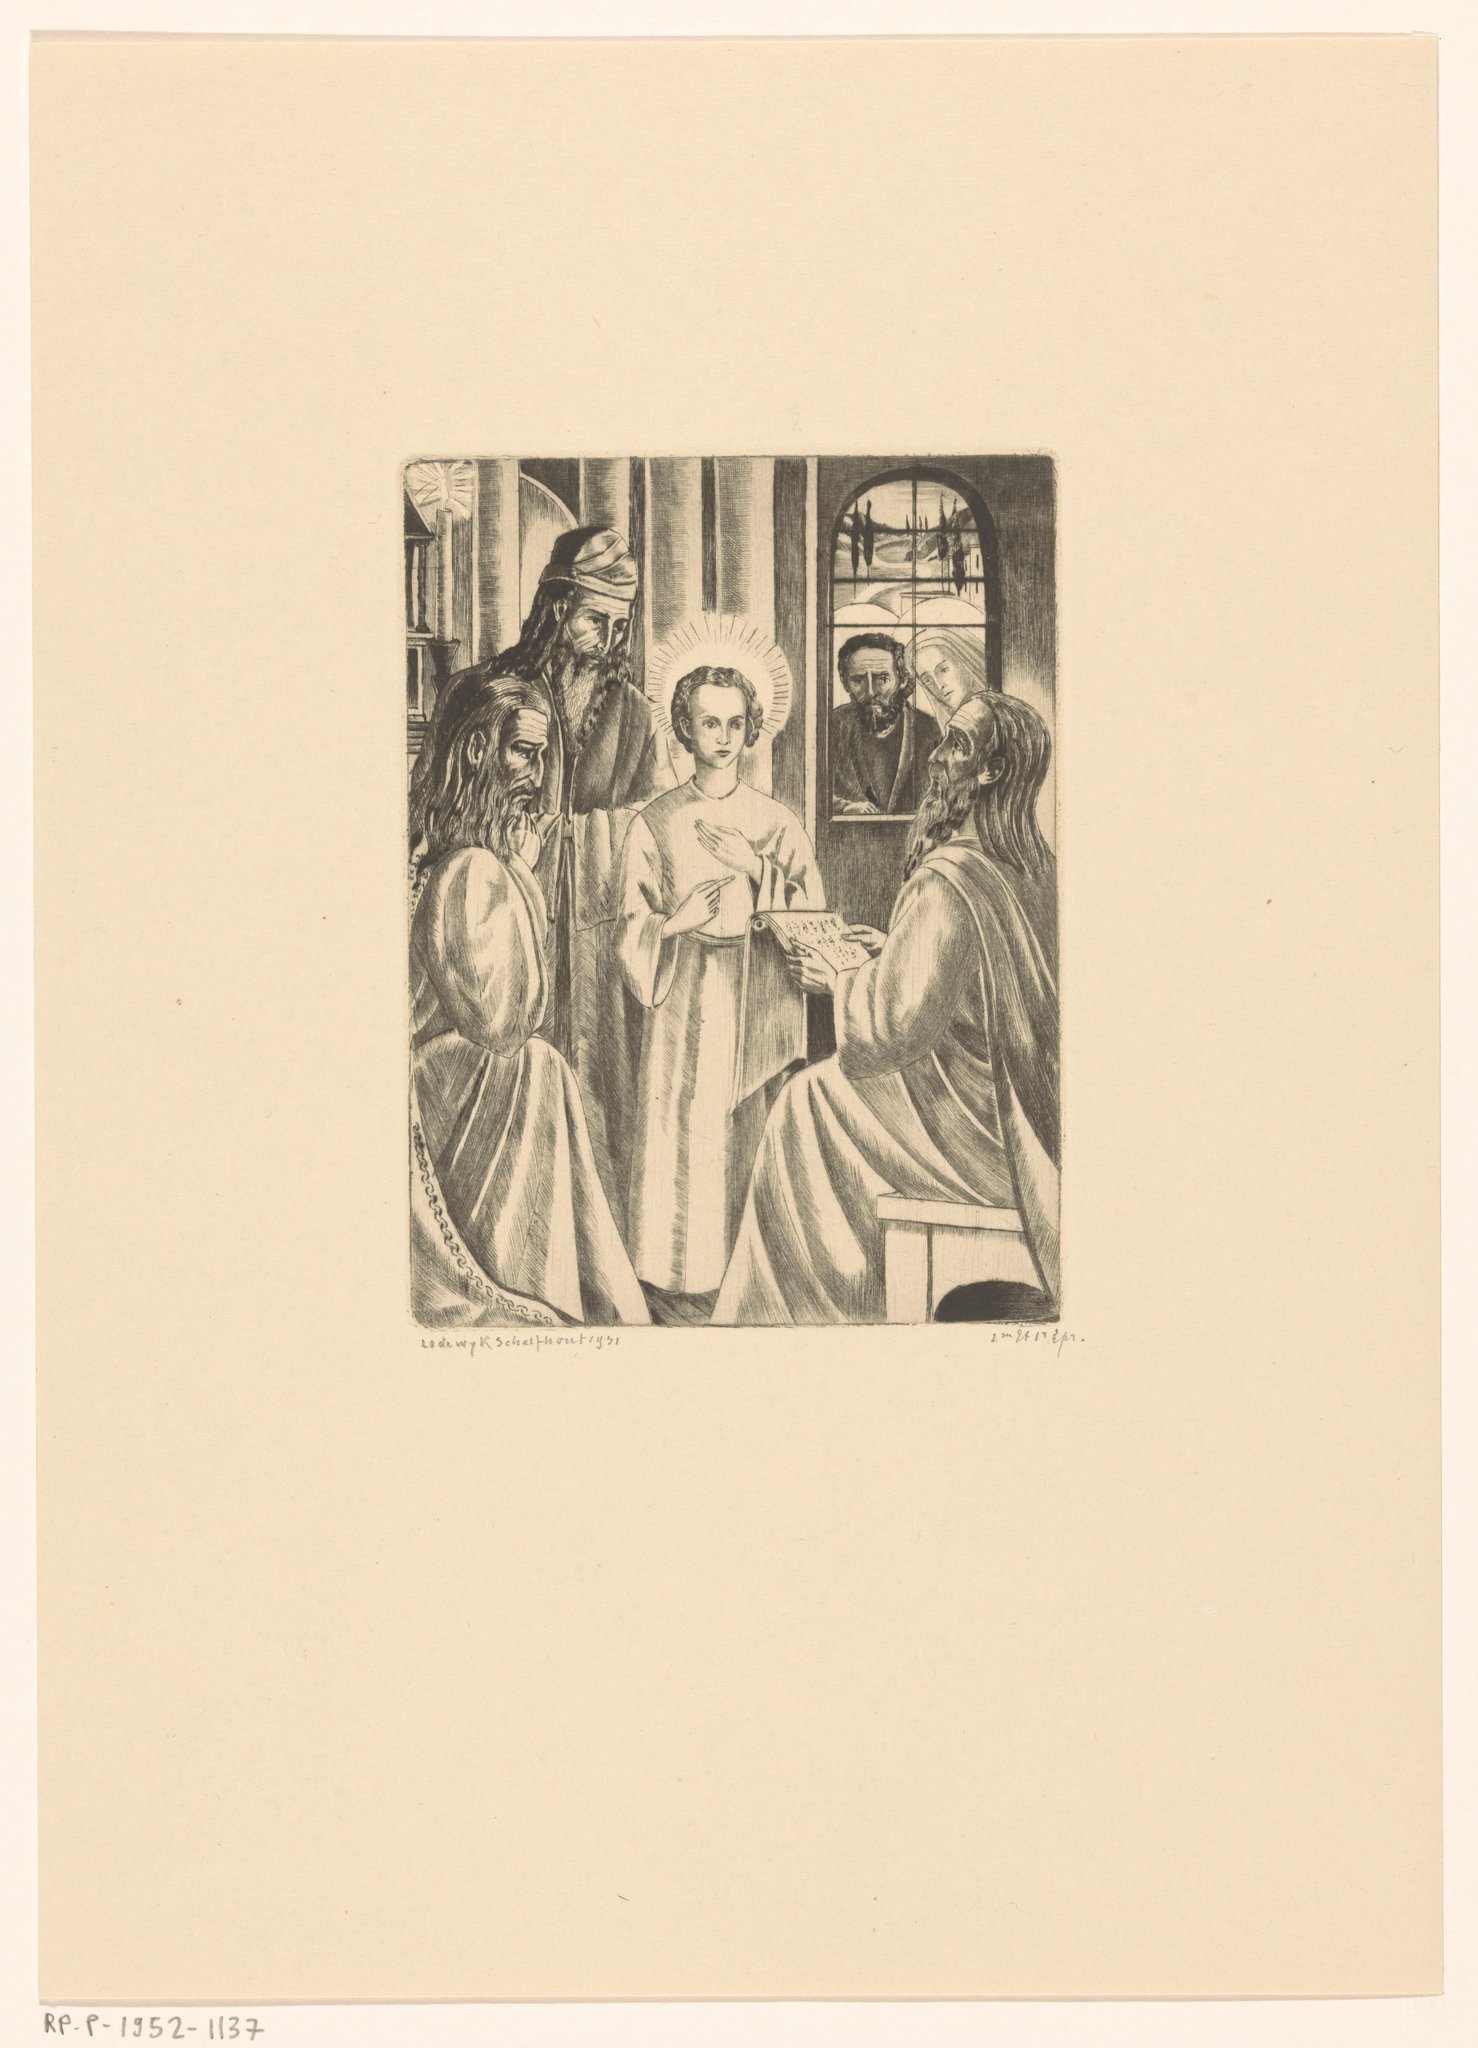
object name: print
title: Twaalfjarige Christus in de tempel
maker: lodewijk schelfhout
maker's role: draughtsman, print maker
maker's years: 1881-1943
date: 1931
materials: paper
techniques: drypoint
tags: christ's dispute with the doctors in the temple; he counts his arguments on his fingers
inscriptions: collector's mark: Lugt 2228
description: Christus op twaalfjarige leeftijd, in debat gewikkeld met drie bebaarde, joodse schriftgeleerden in de tempel van Salomo. Eén van de geleerden houdt een boek vast in de vorm van een rol. Maria en Jozef, die naar hun zoon op zoek waren, bekijken het tafereel door een raam.